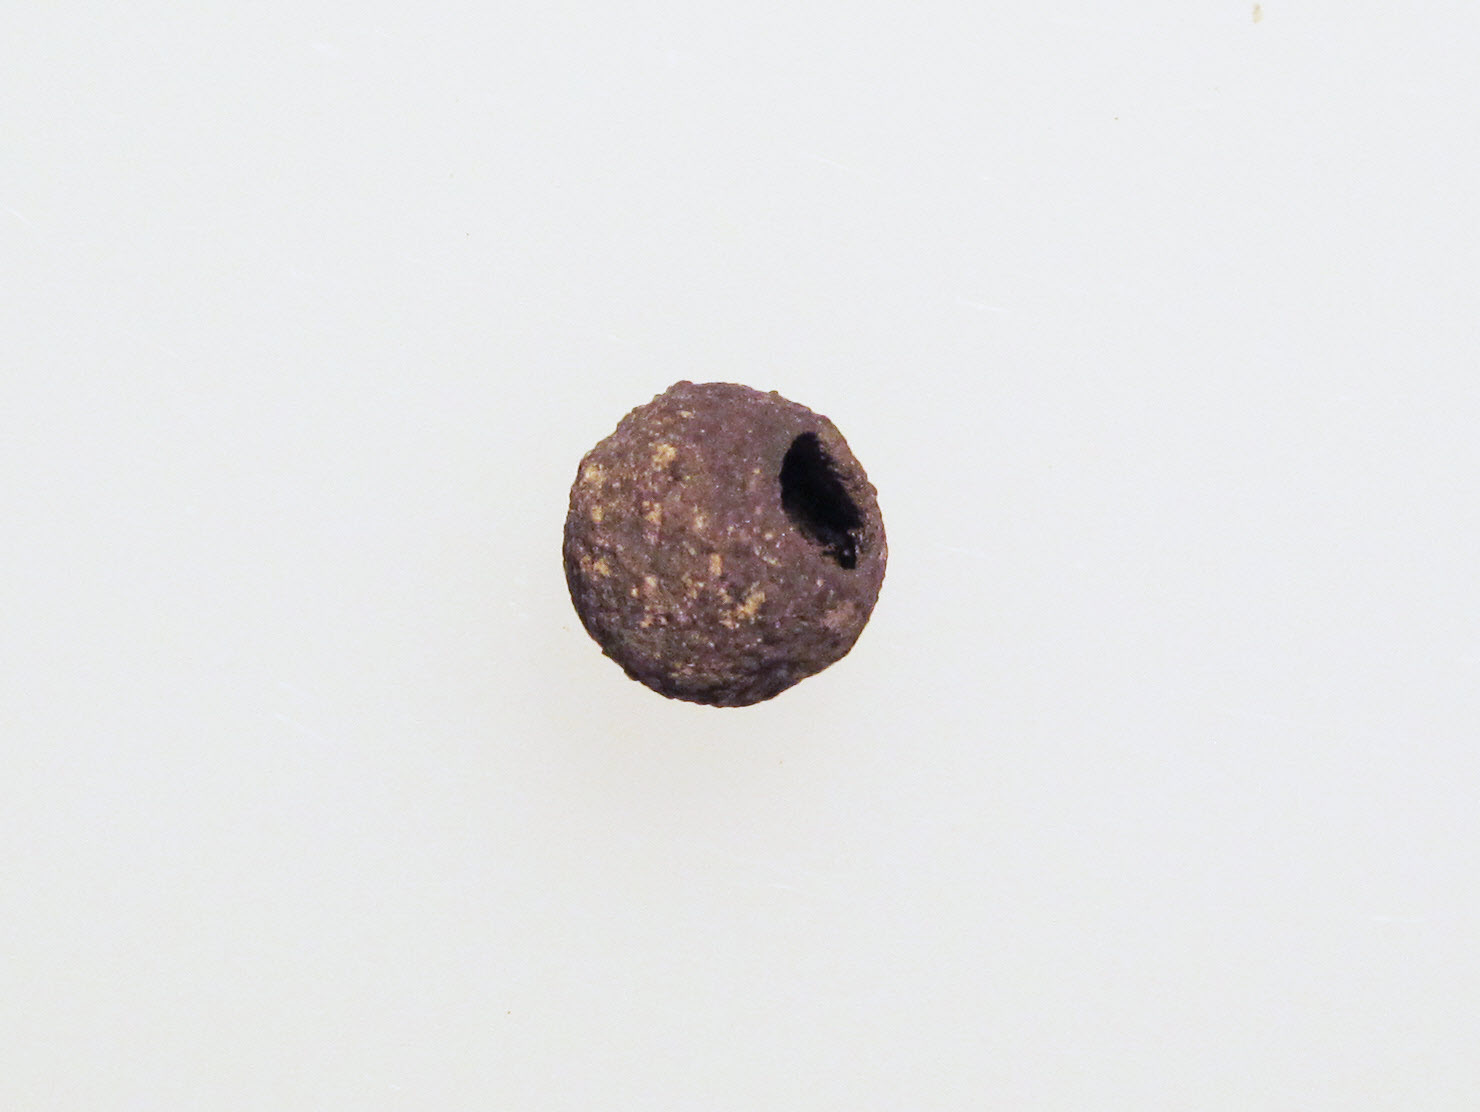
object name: bead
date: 7000 BCE-330 CE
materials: silver